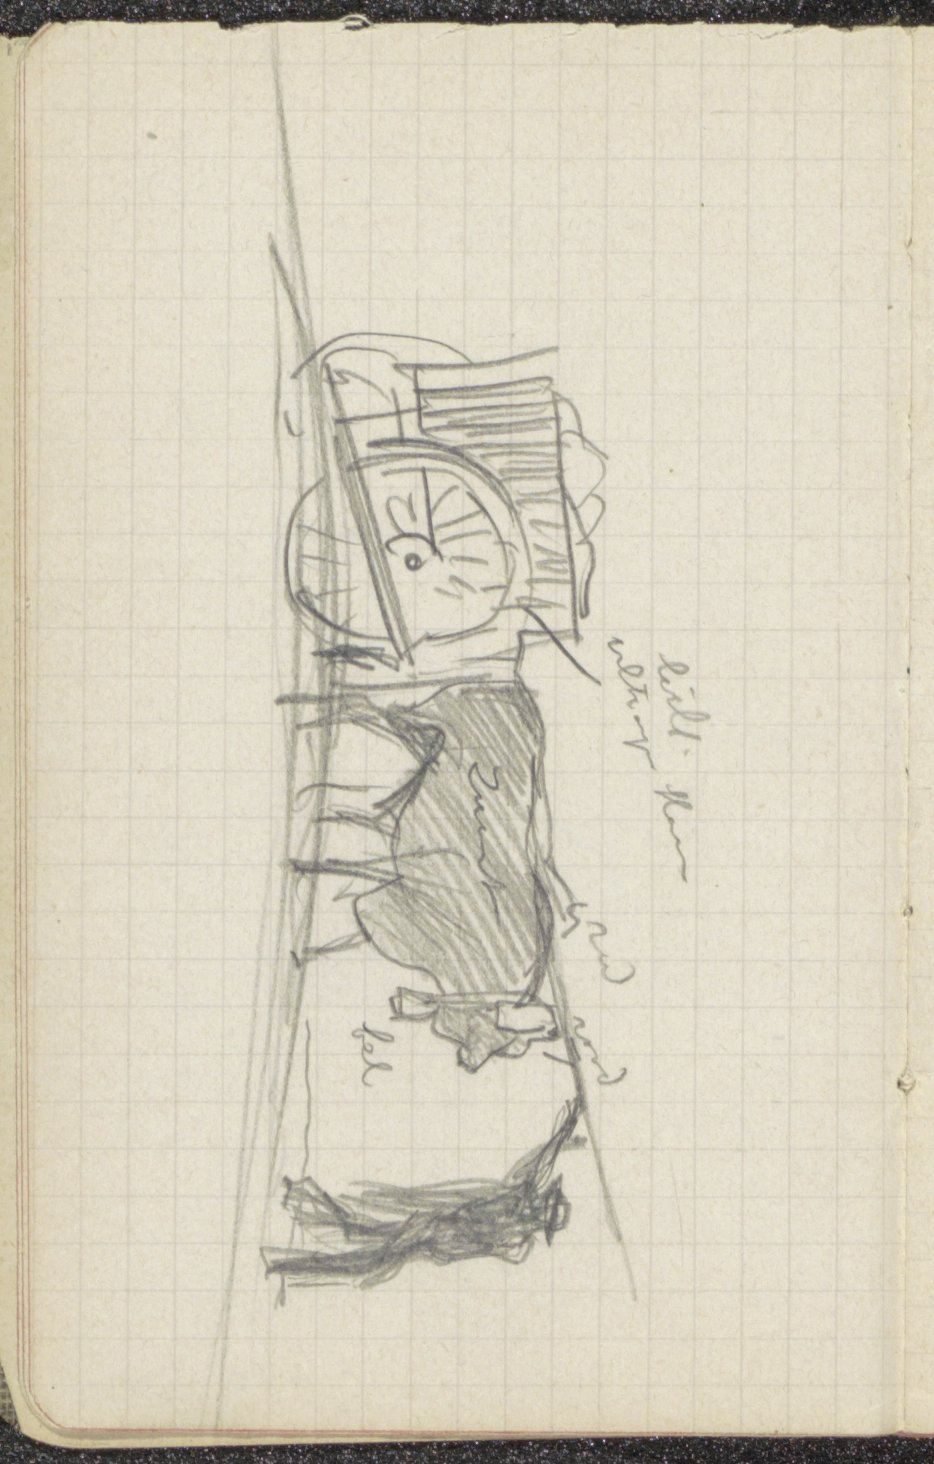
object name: sketchbook leaf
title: Man bij een ossenkar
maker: marius bauer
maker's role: draughtsman, print maker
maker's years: 1867-1932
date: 1902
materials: pencil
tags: standing figure, ox, (farm) wagon, freight wagon, cart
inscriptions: annotation: ‘bel’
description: De os draagt een bel om de nek. Pagina 6 uit een schetsboek met 23 bladen.